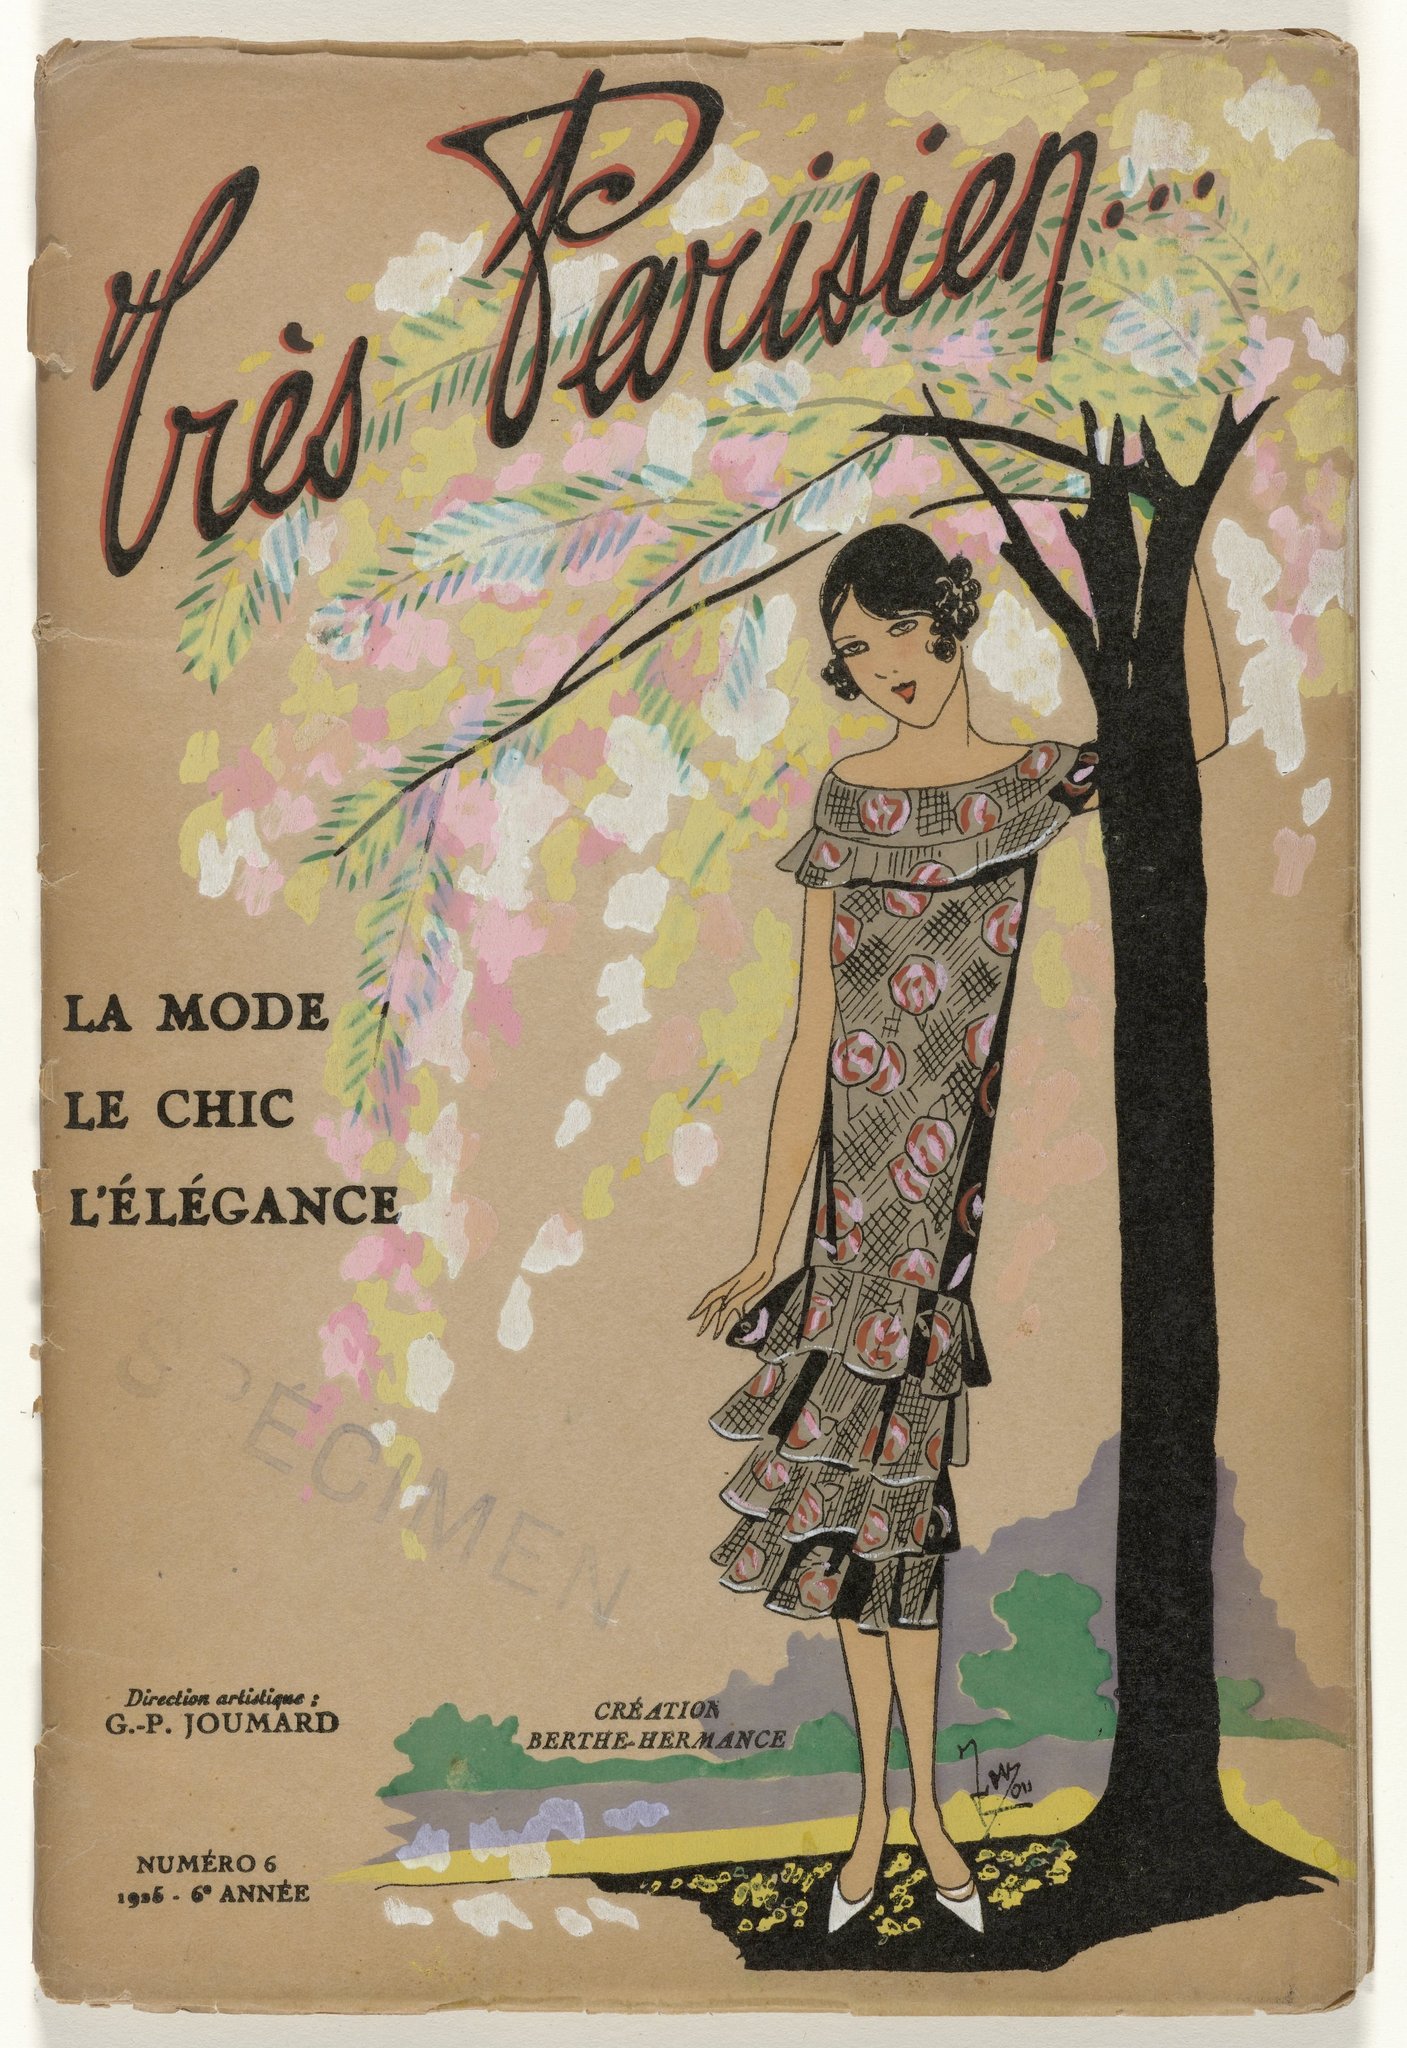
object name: magazine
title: Très Parisien (...)La Mode Le Chic L'Élégance 1925, Numéro 6, 1925-6e Année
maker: g-p. joumard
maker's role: publisher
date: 1925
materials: paper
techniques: letterpress printing, pochoir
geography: paris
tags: fashion plates, dress, gown (+ women's clothes)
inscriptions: title: ‘Très Parisien...La Mode Le Chic L'Élégance 1925, Numéro 6, 1925-6e Année’, address: ‘Direction artistique: G.-P. Joumard’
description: Très Parisien: zes pagina's tekst in boekdruk over de zomercollectie van 1925, 18 prenten met modellen in pochoir techniek, vijf pagina's met gedetailleerde schetsen en beschrijvingen van de getoonde ontwerpen en drie pagina's advertenties. In omslag in pochoir techniek.